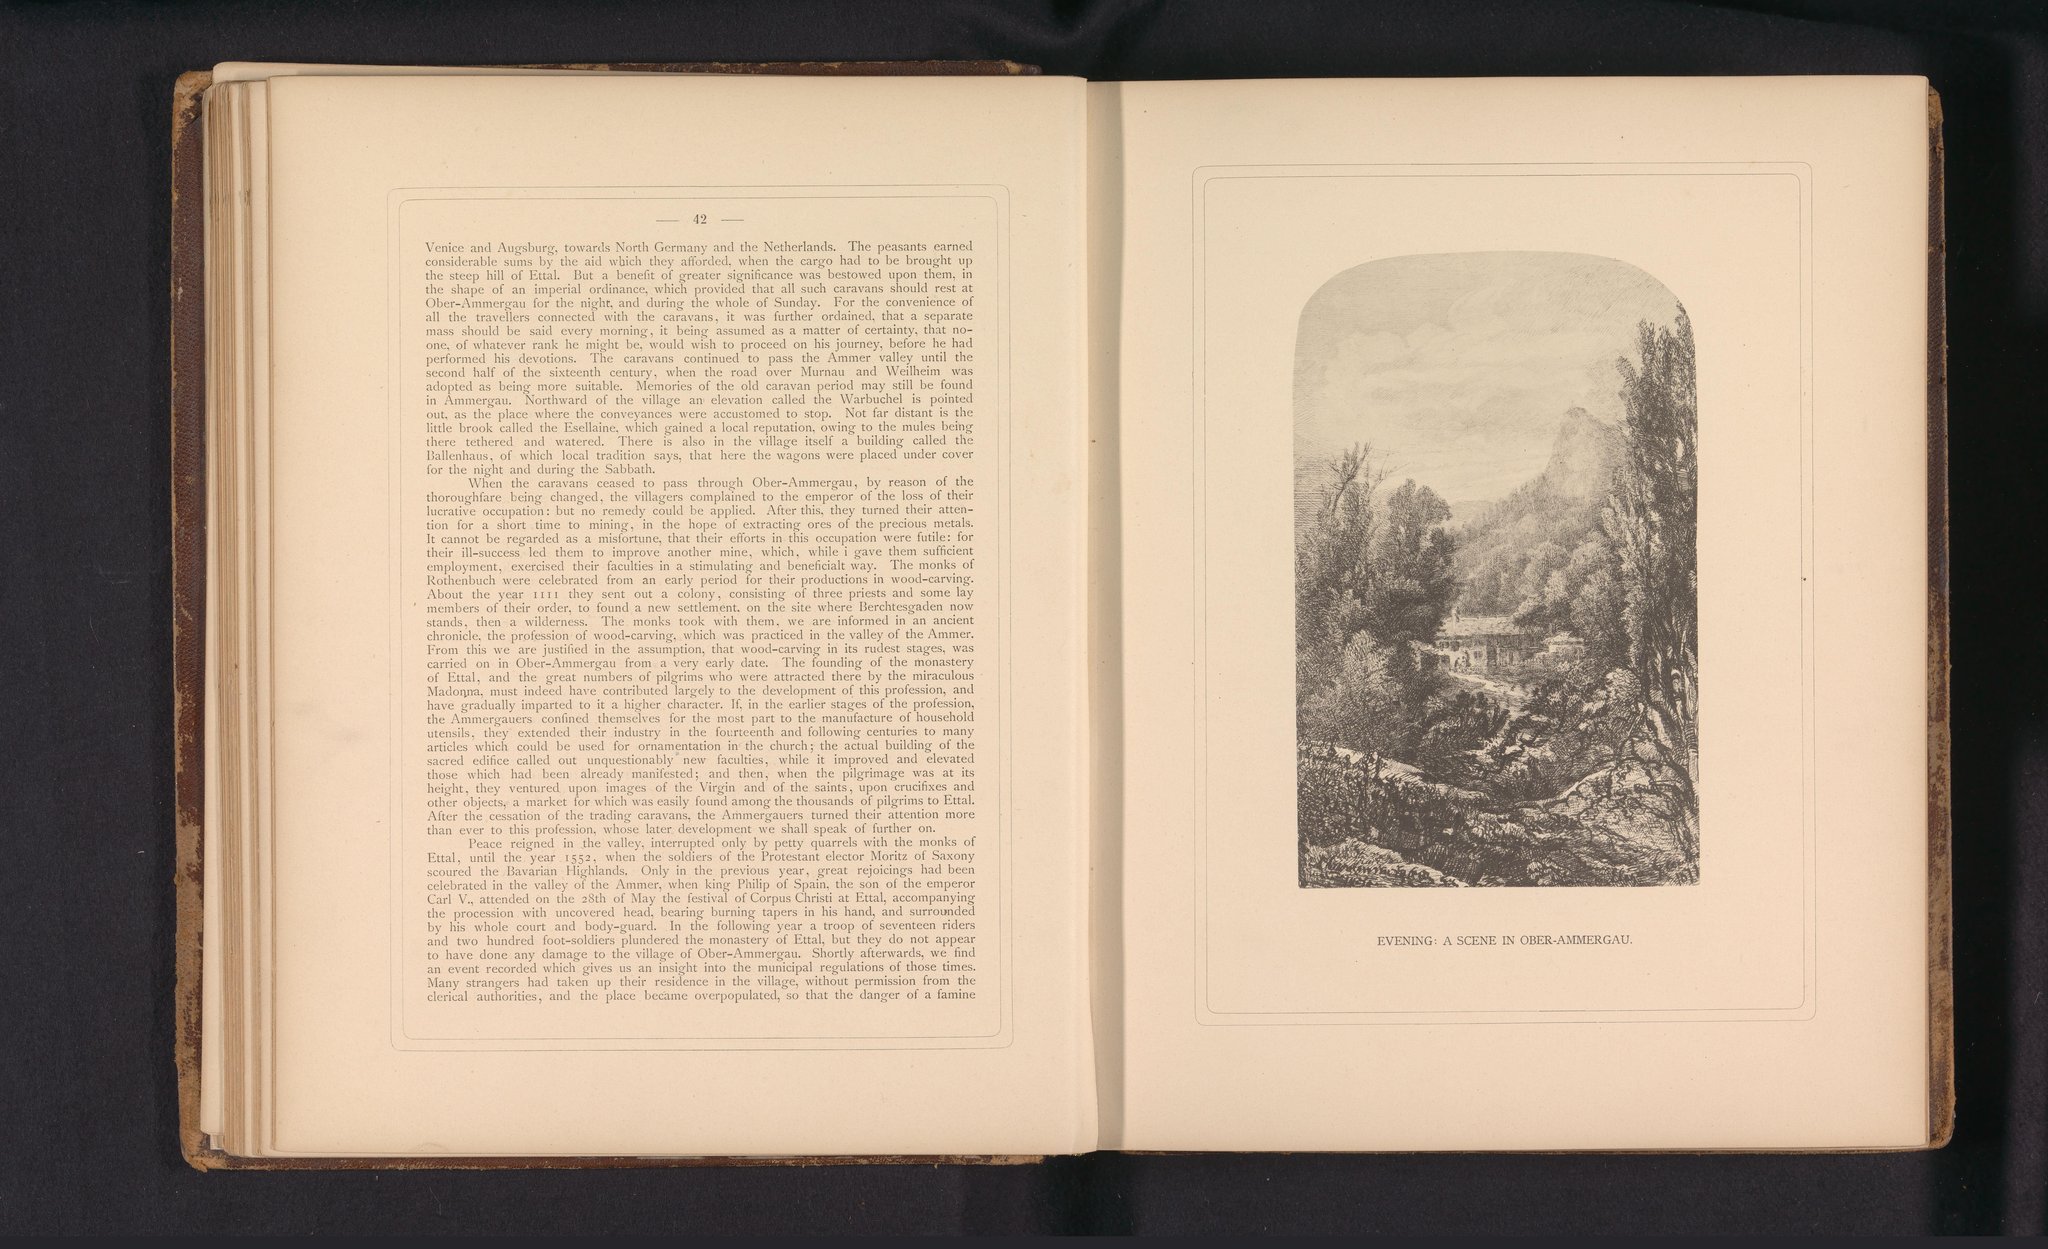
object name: reproduction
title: Evening: a scene in Ober-Ammergau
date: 1868-1873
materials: paper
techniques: photograph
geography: oberammergau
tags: city-view in general; 'veduta', oberammergau